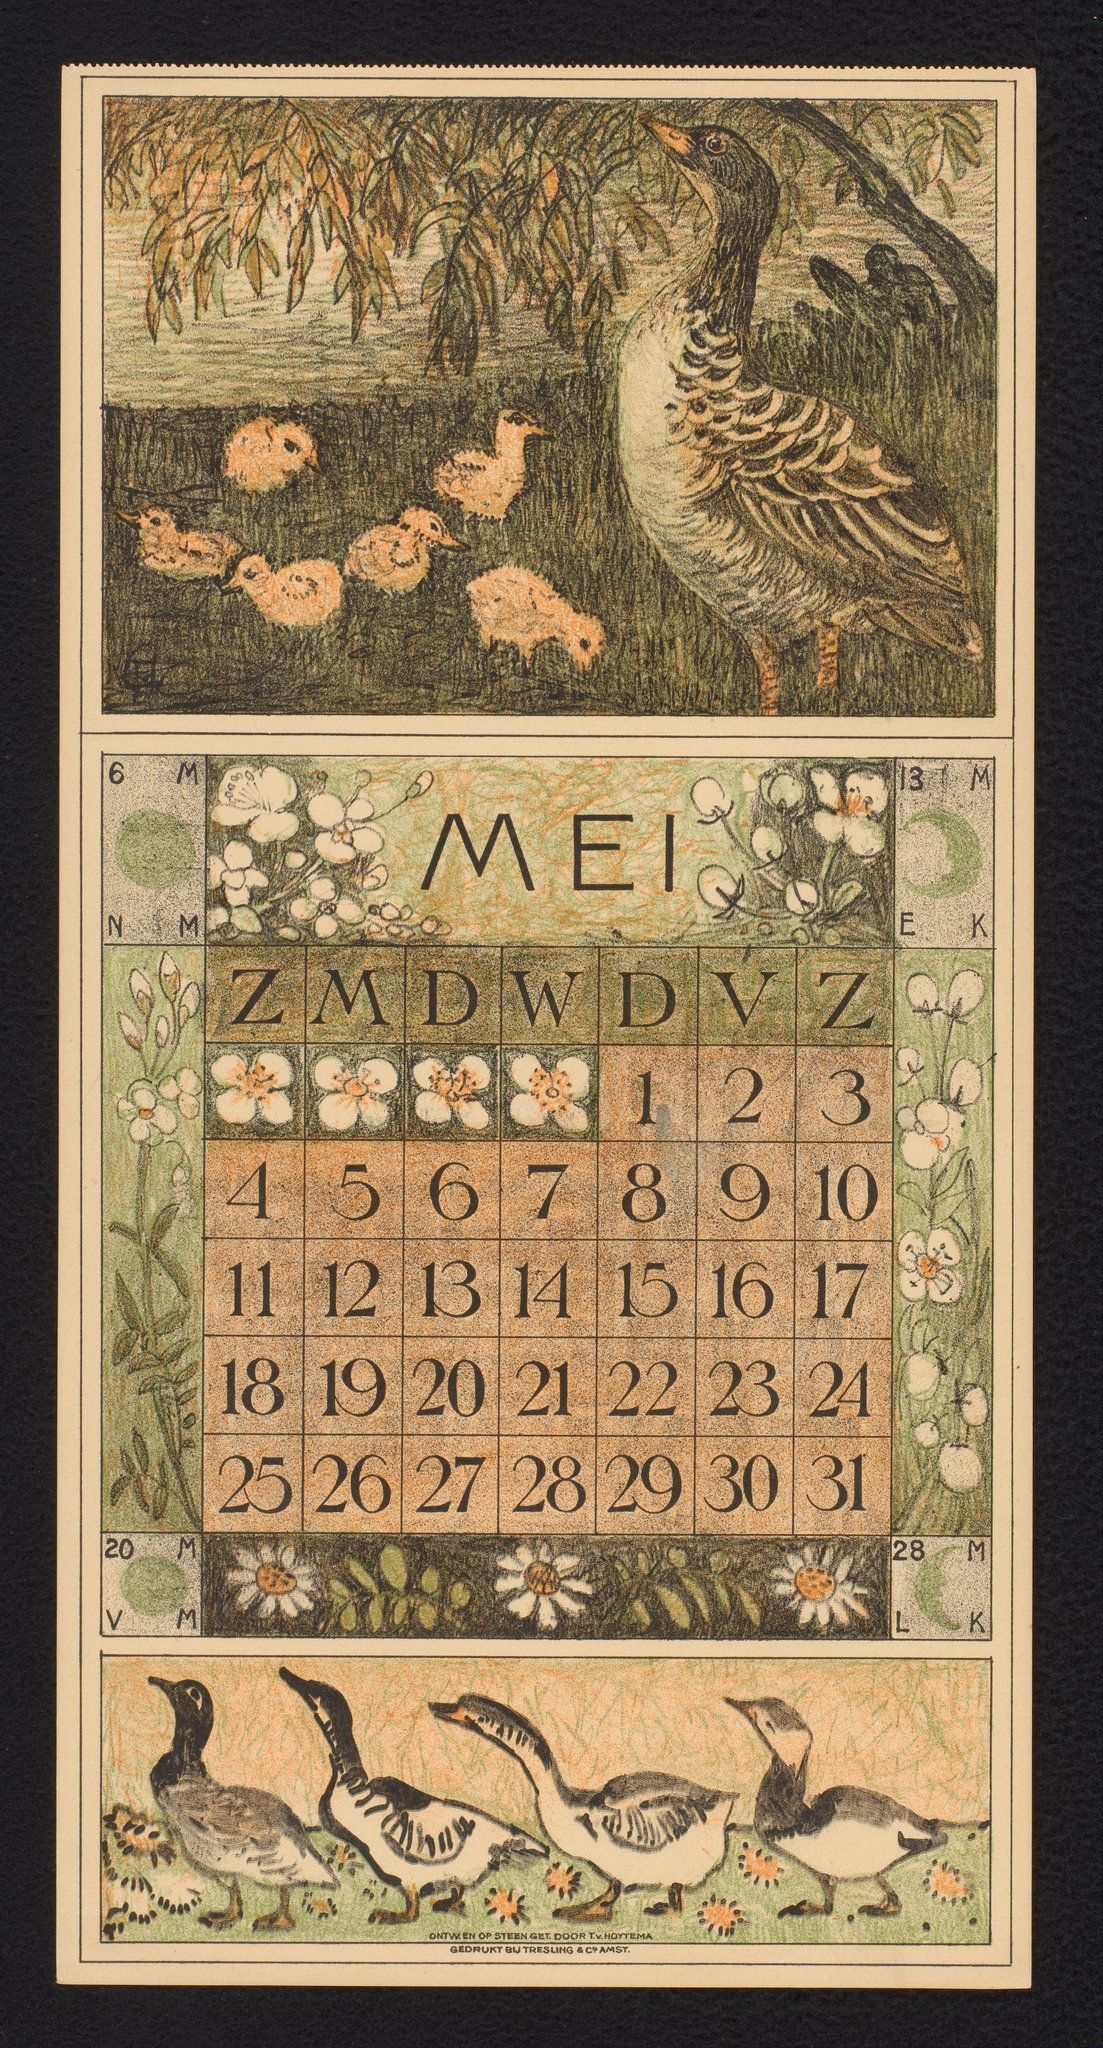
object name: print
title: Kalenderblad voor mei 1913 met een eend met kuikens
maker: theo van hoytema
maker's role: draughtsman, painter, print maker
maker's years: 1863-1917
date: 1912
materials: paper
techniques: lithograph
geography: amsterdam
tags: water-birds: goose, ducks (domestic waterbirds), water-birds: duck